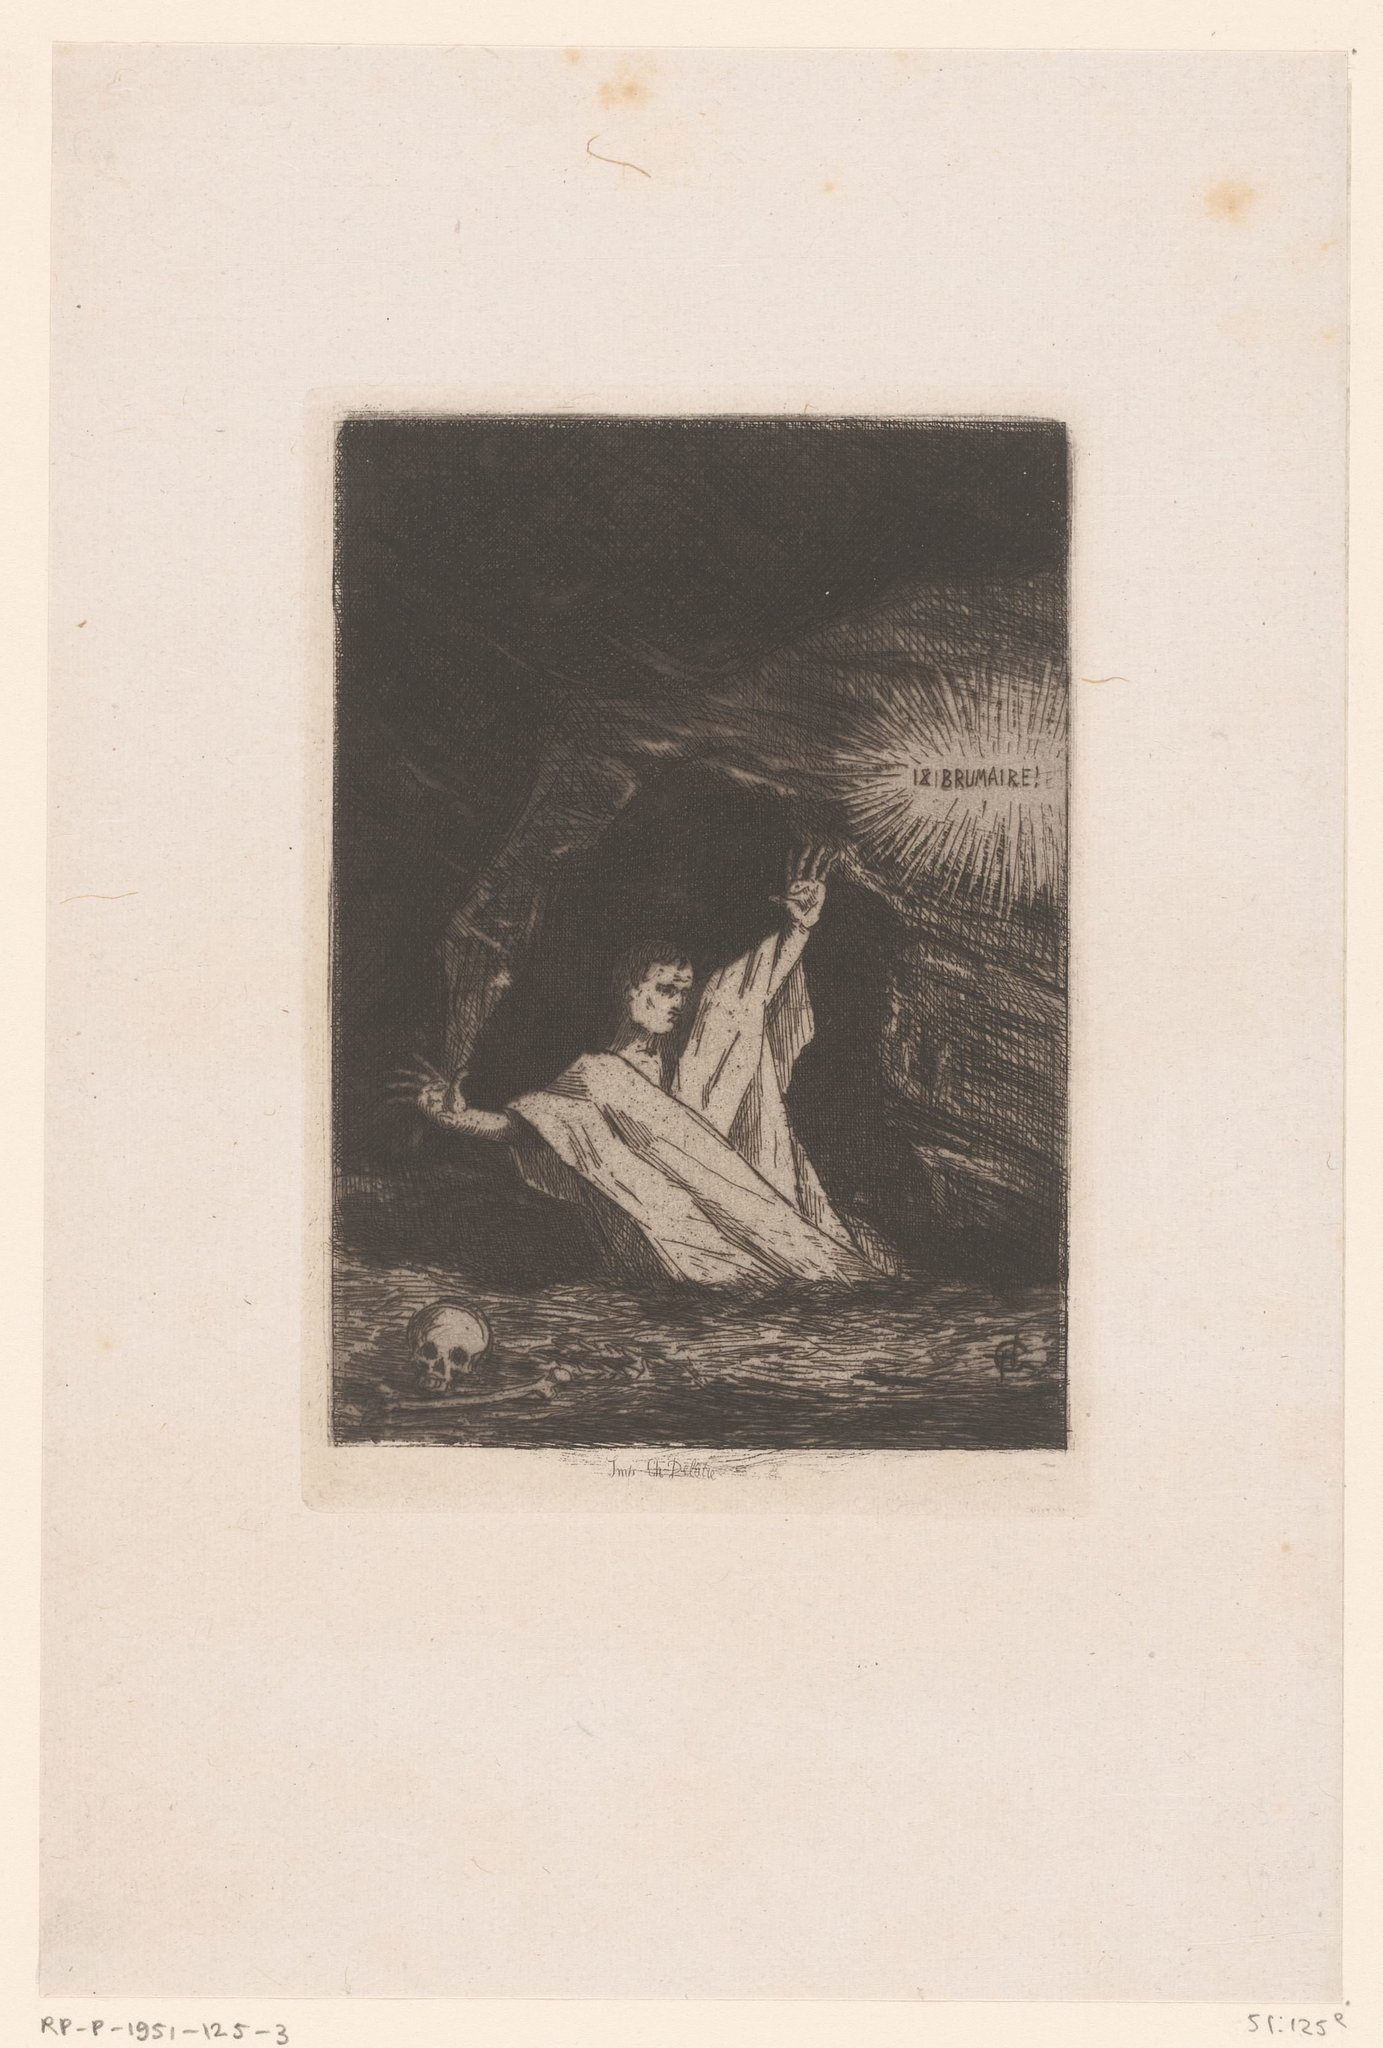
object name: print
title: Illustraties bij Les Châtiments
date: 1856-1897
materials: paper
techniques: etching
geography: paris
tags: napoleon i (emperor of the french), historical persons, grave, tomb, illustration ~ printed matter, book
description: Maakt deel uit van een tiendelige serie met illustraties bij de dichtbundel 'Les Châtiments' (1853) door Victor Hugo. De tekst werd wegens een anti-napoleontisch sentiment in Frankrijk verboden. Daarom werd de serie in de eerste instantie in Brussel uitgegeven. Deze editie werd echter in Parijs gepubliceerd door de Libraire Nouvelle. Op de achterzijde van de papieren omslag wordt reclame gemaakt voor een serie eveneens door Guérard met illustraties bij 'Napoléon le Petit' door Victor Hugo. De prent illustreert enkele regels uit het gedicht 'L'expiation'. Op het opzetvel is betreffende passage geplakt.